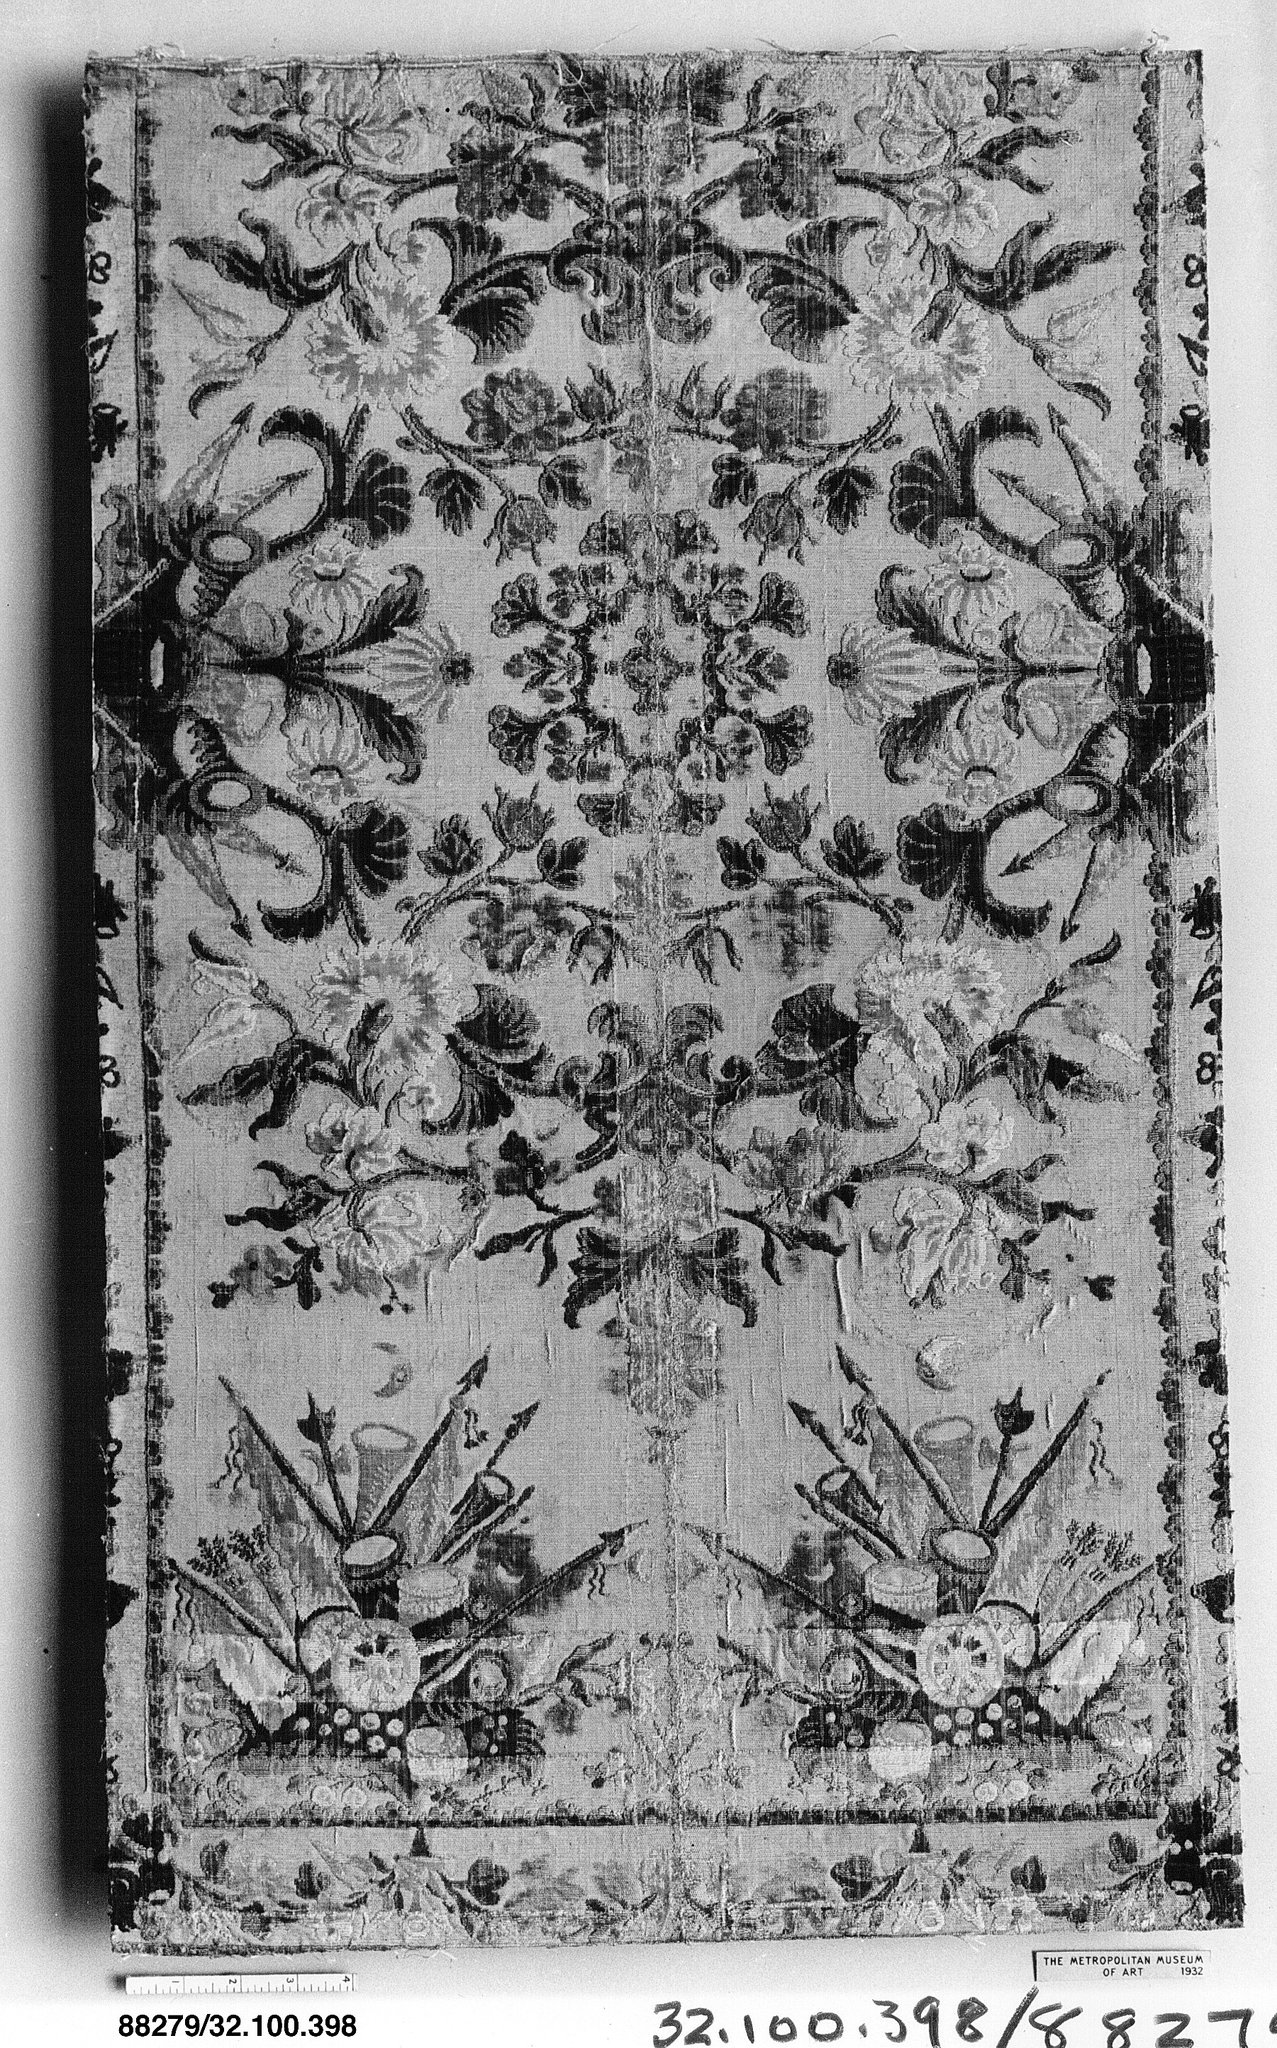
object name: piece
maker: giovanni baritta and the marzari sons, quarter of san giacomo, venice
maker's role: maker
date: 1701-1800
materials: silk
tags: flowers